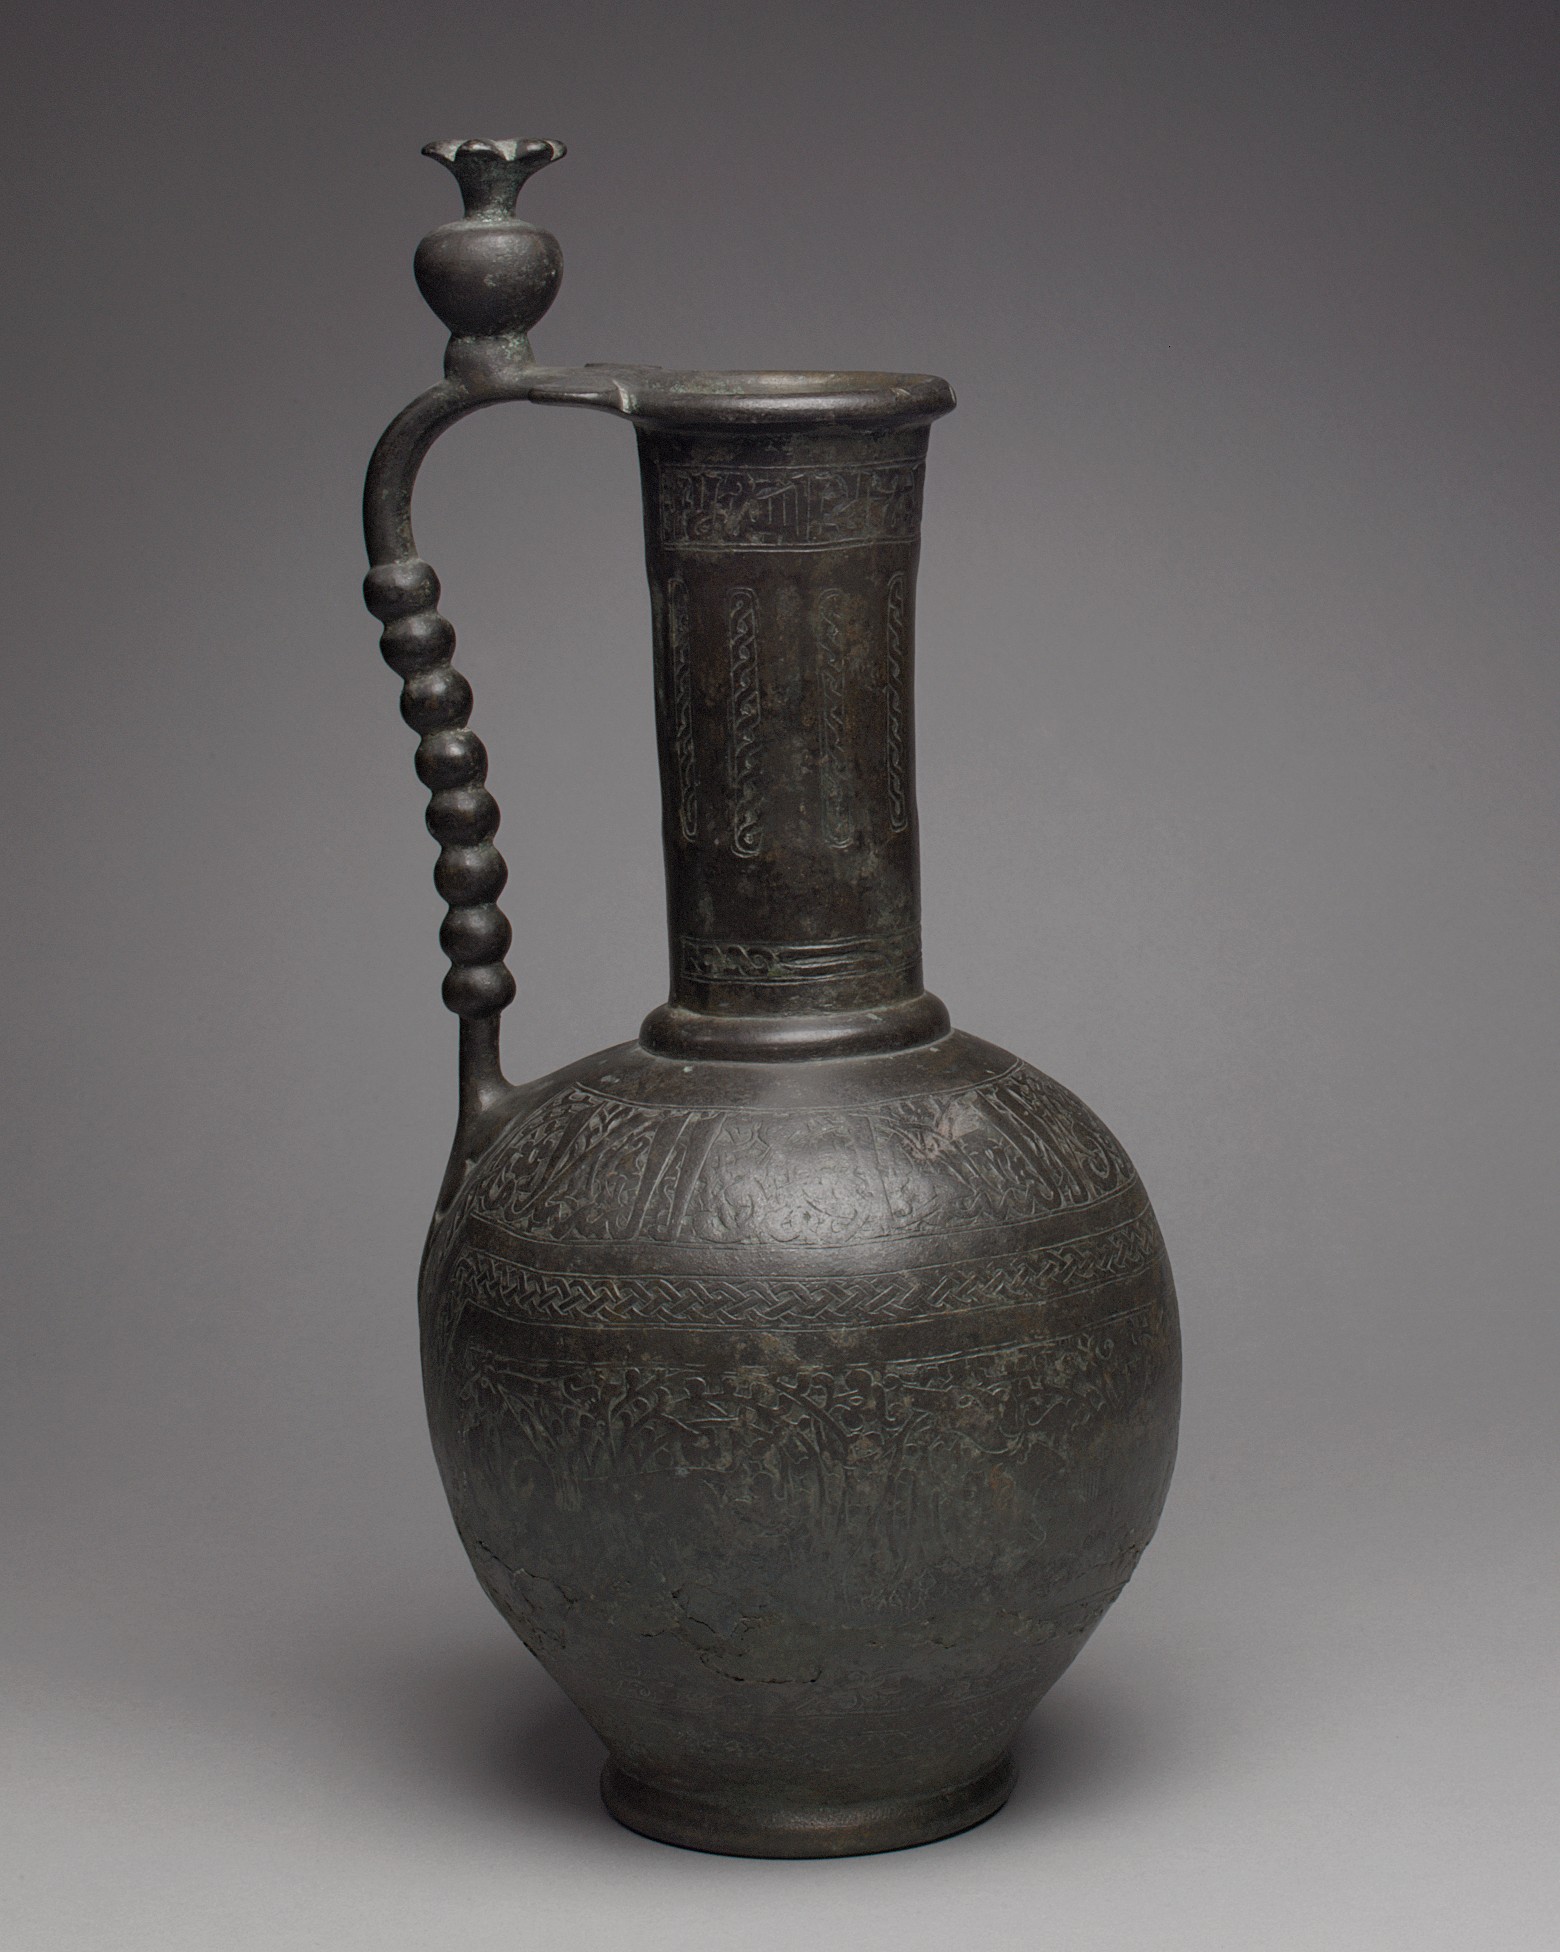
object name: ewer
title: Ewer with Inscriptions and Hunting Scenes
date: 1001-1100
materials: bronze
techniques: casting, engraving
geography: iran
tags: men,arabic,hunting,dogs,rabbits